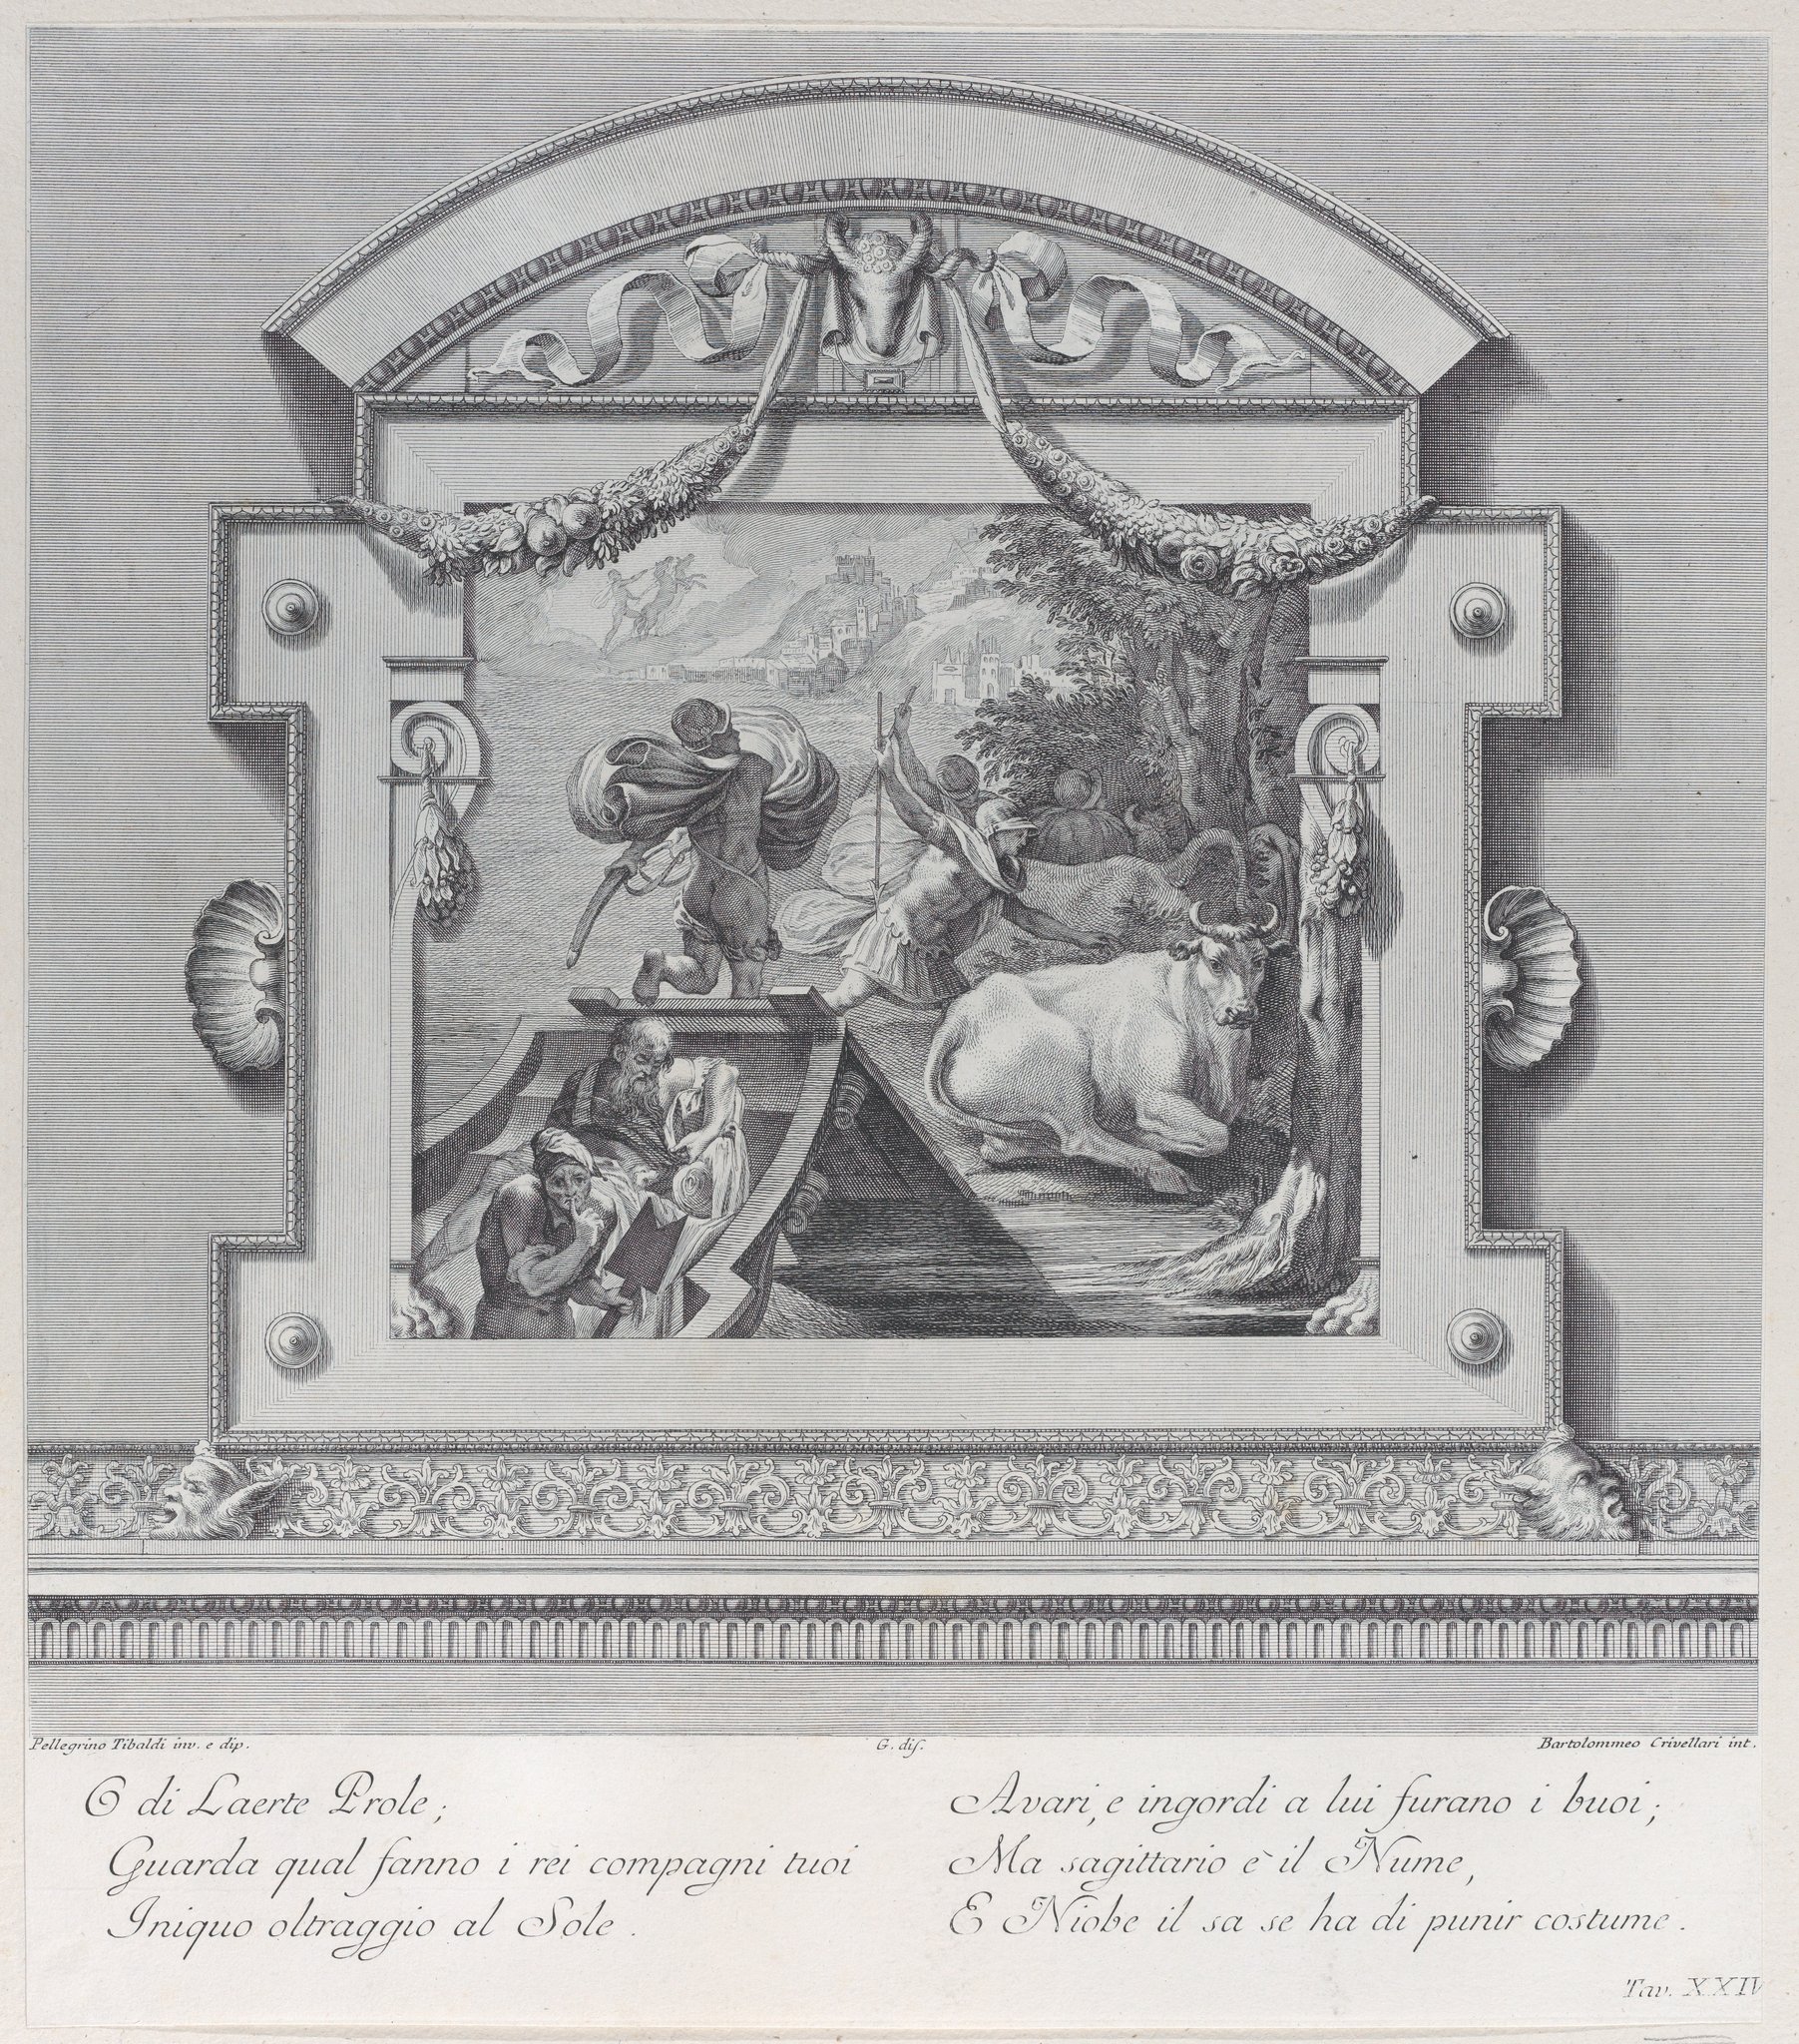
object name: print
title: Plate 24: Ulysses's companions stealing the oxen sacred to Apollo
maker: bartolomeo crivellari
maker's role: artist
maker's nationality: italian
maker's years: 1700-1800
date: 1756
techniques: engraving, etching